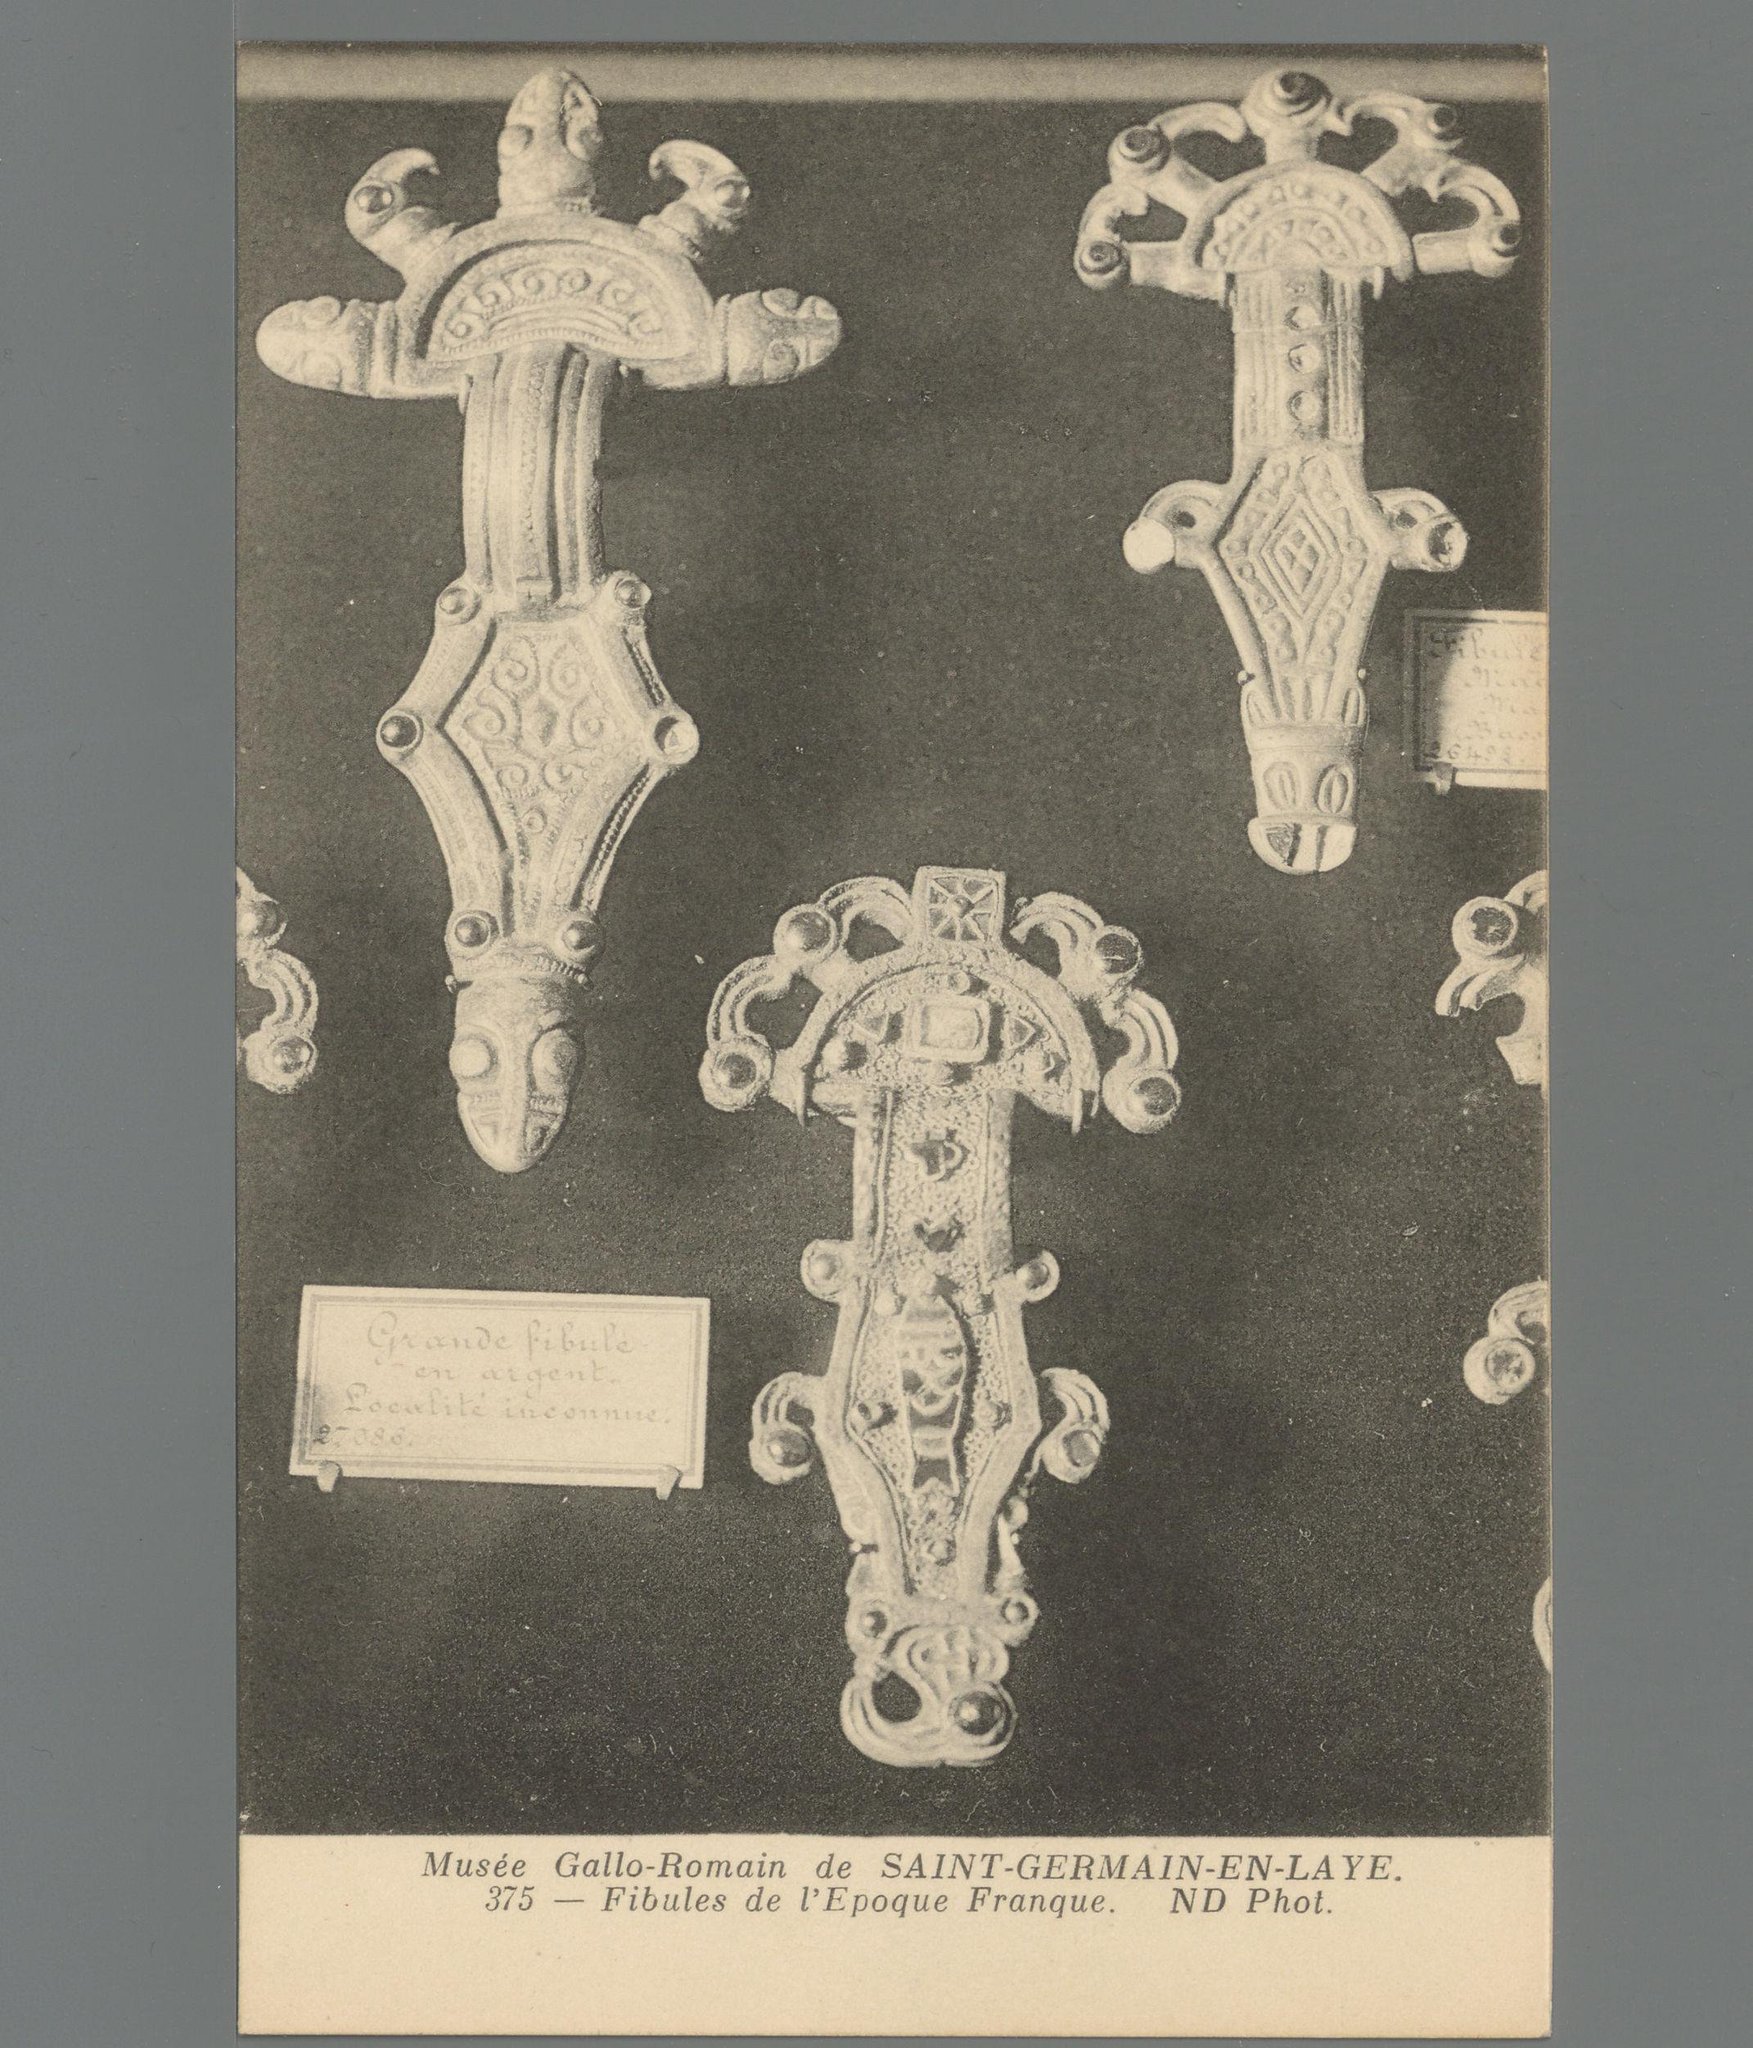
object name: ansichtkaart, prentbriefkaart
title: Musée Gallo-Romain de Saint-Germain-en-Laye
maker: Anonymous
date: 1903-1918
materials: cardboard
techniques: photograph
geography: paris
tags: ornaments, jewels, fibula, safety pin, permanent exhibition, museum